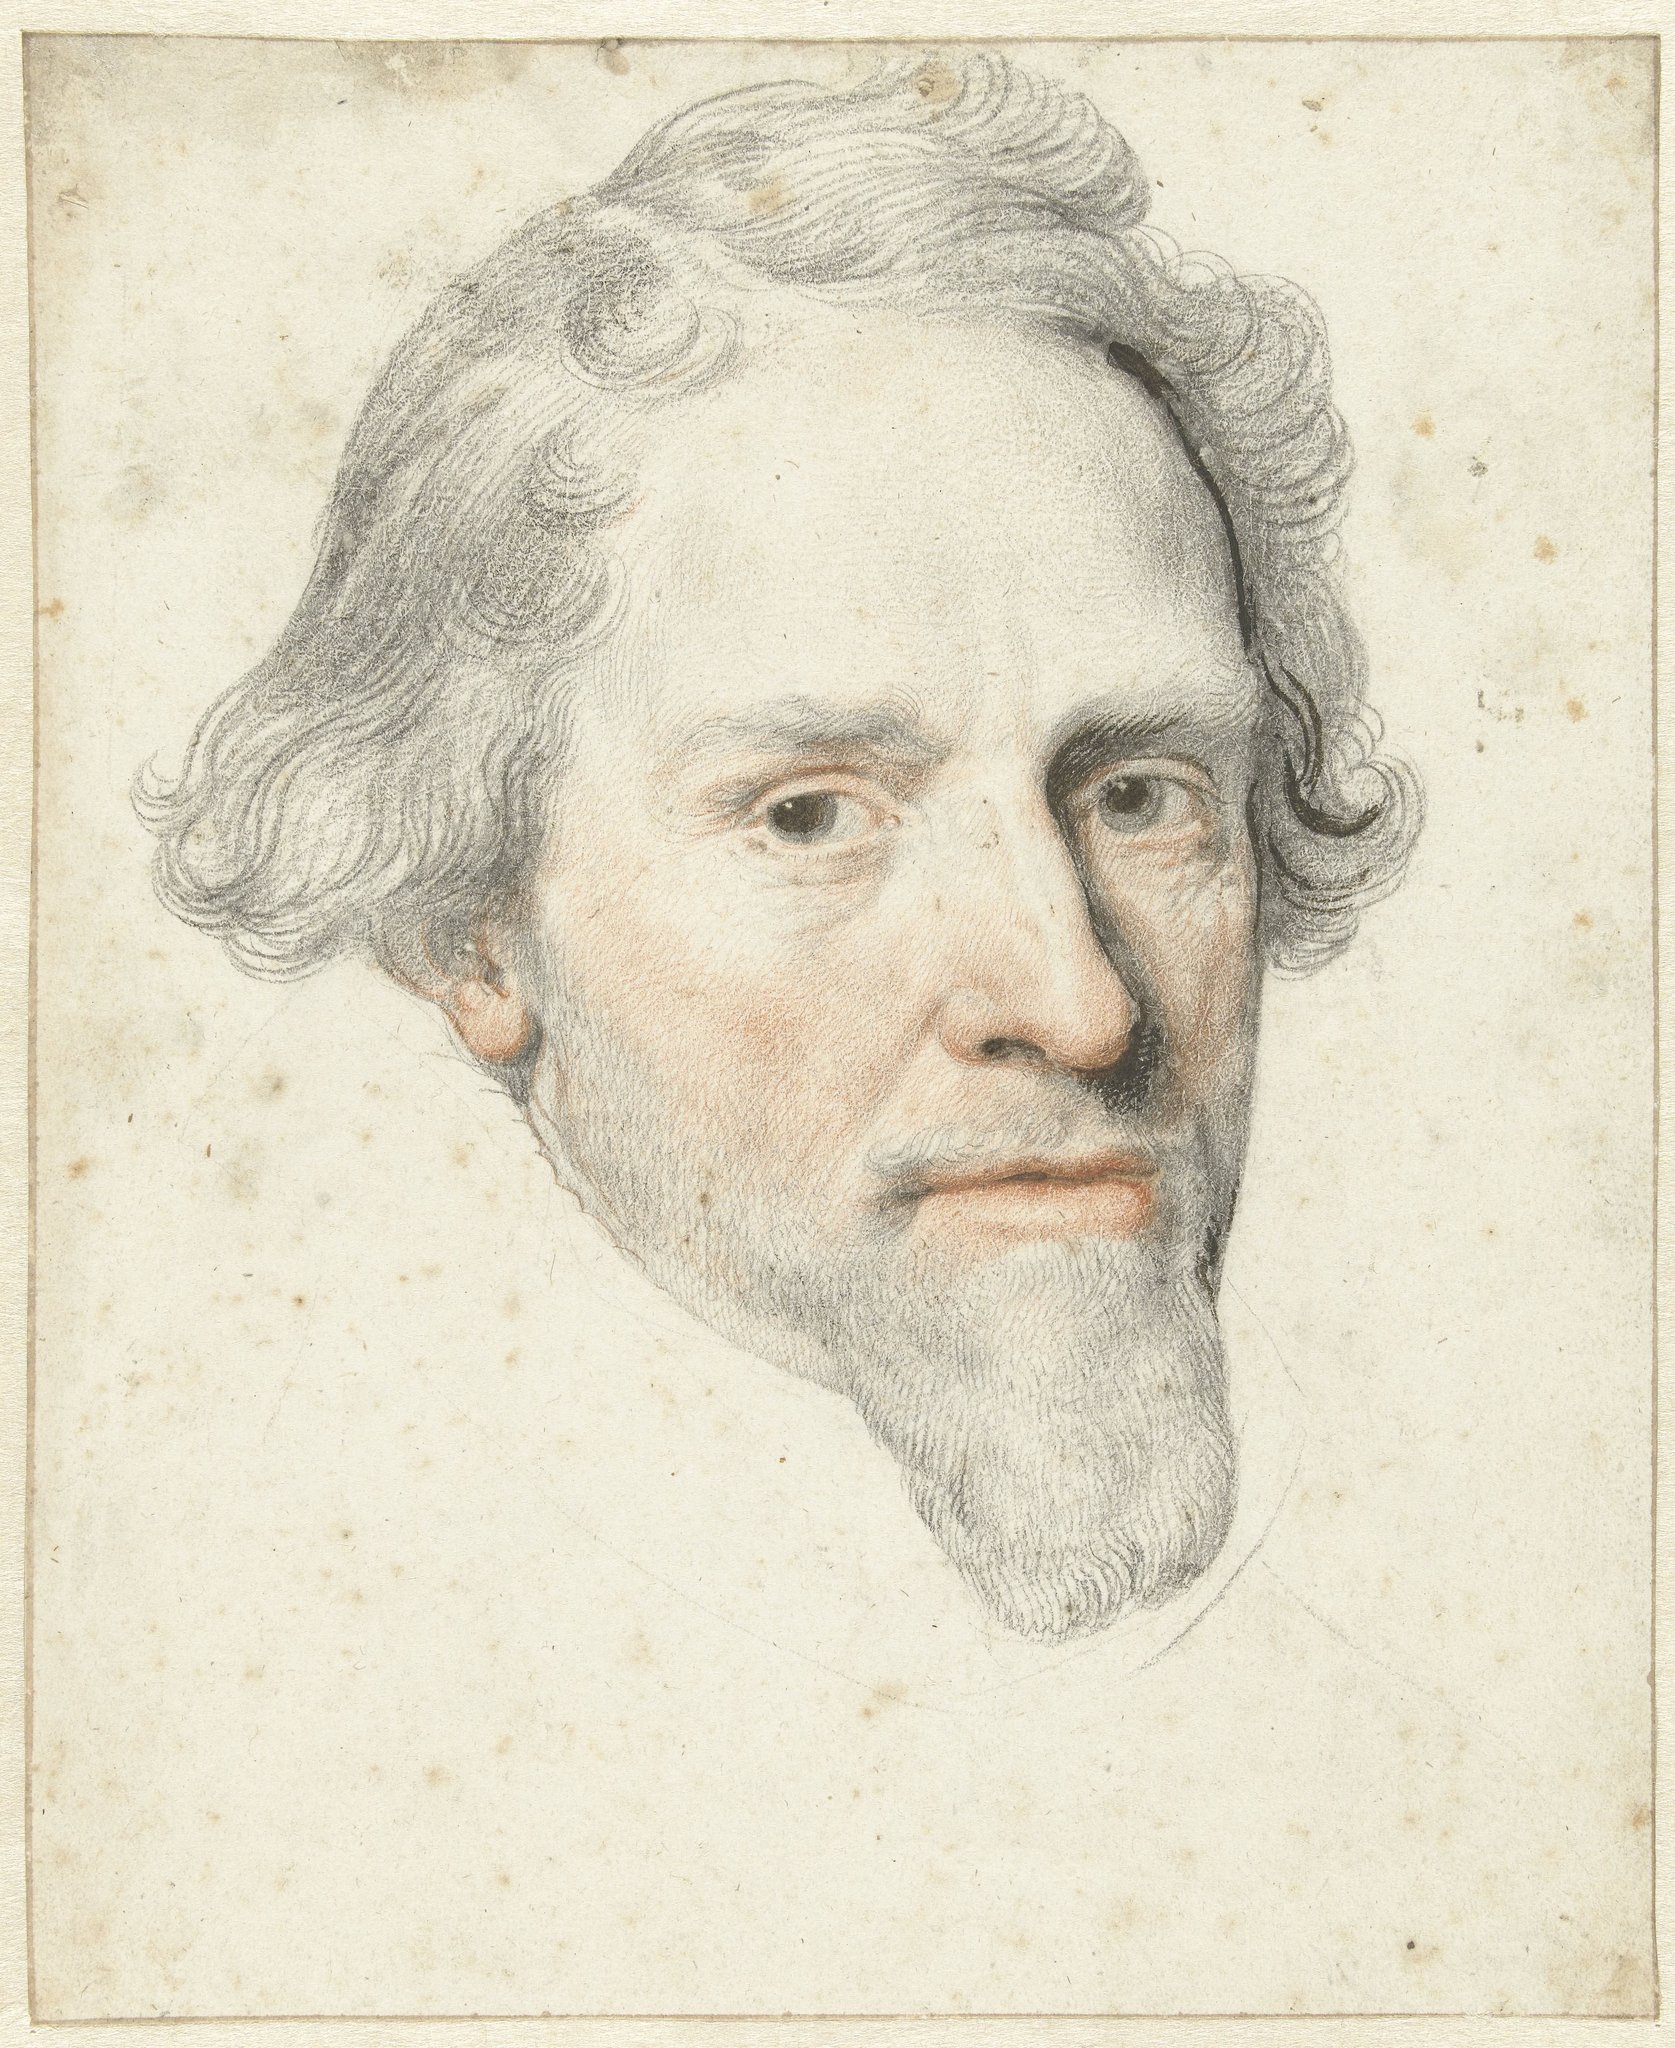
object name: drawing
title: Portret van Prins Maurits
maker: pieter claesz. soutman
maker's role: draughtsman, print maker, publisher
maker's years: 1593-1657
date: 1638-1643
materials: chalk, paper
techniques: brush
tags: maurice (prince of orange), historical persons